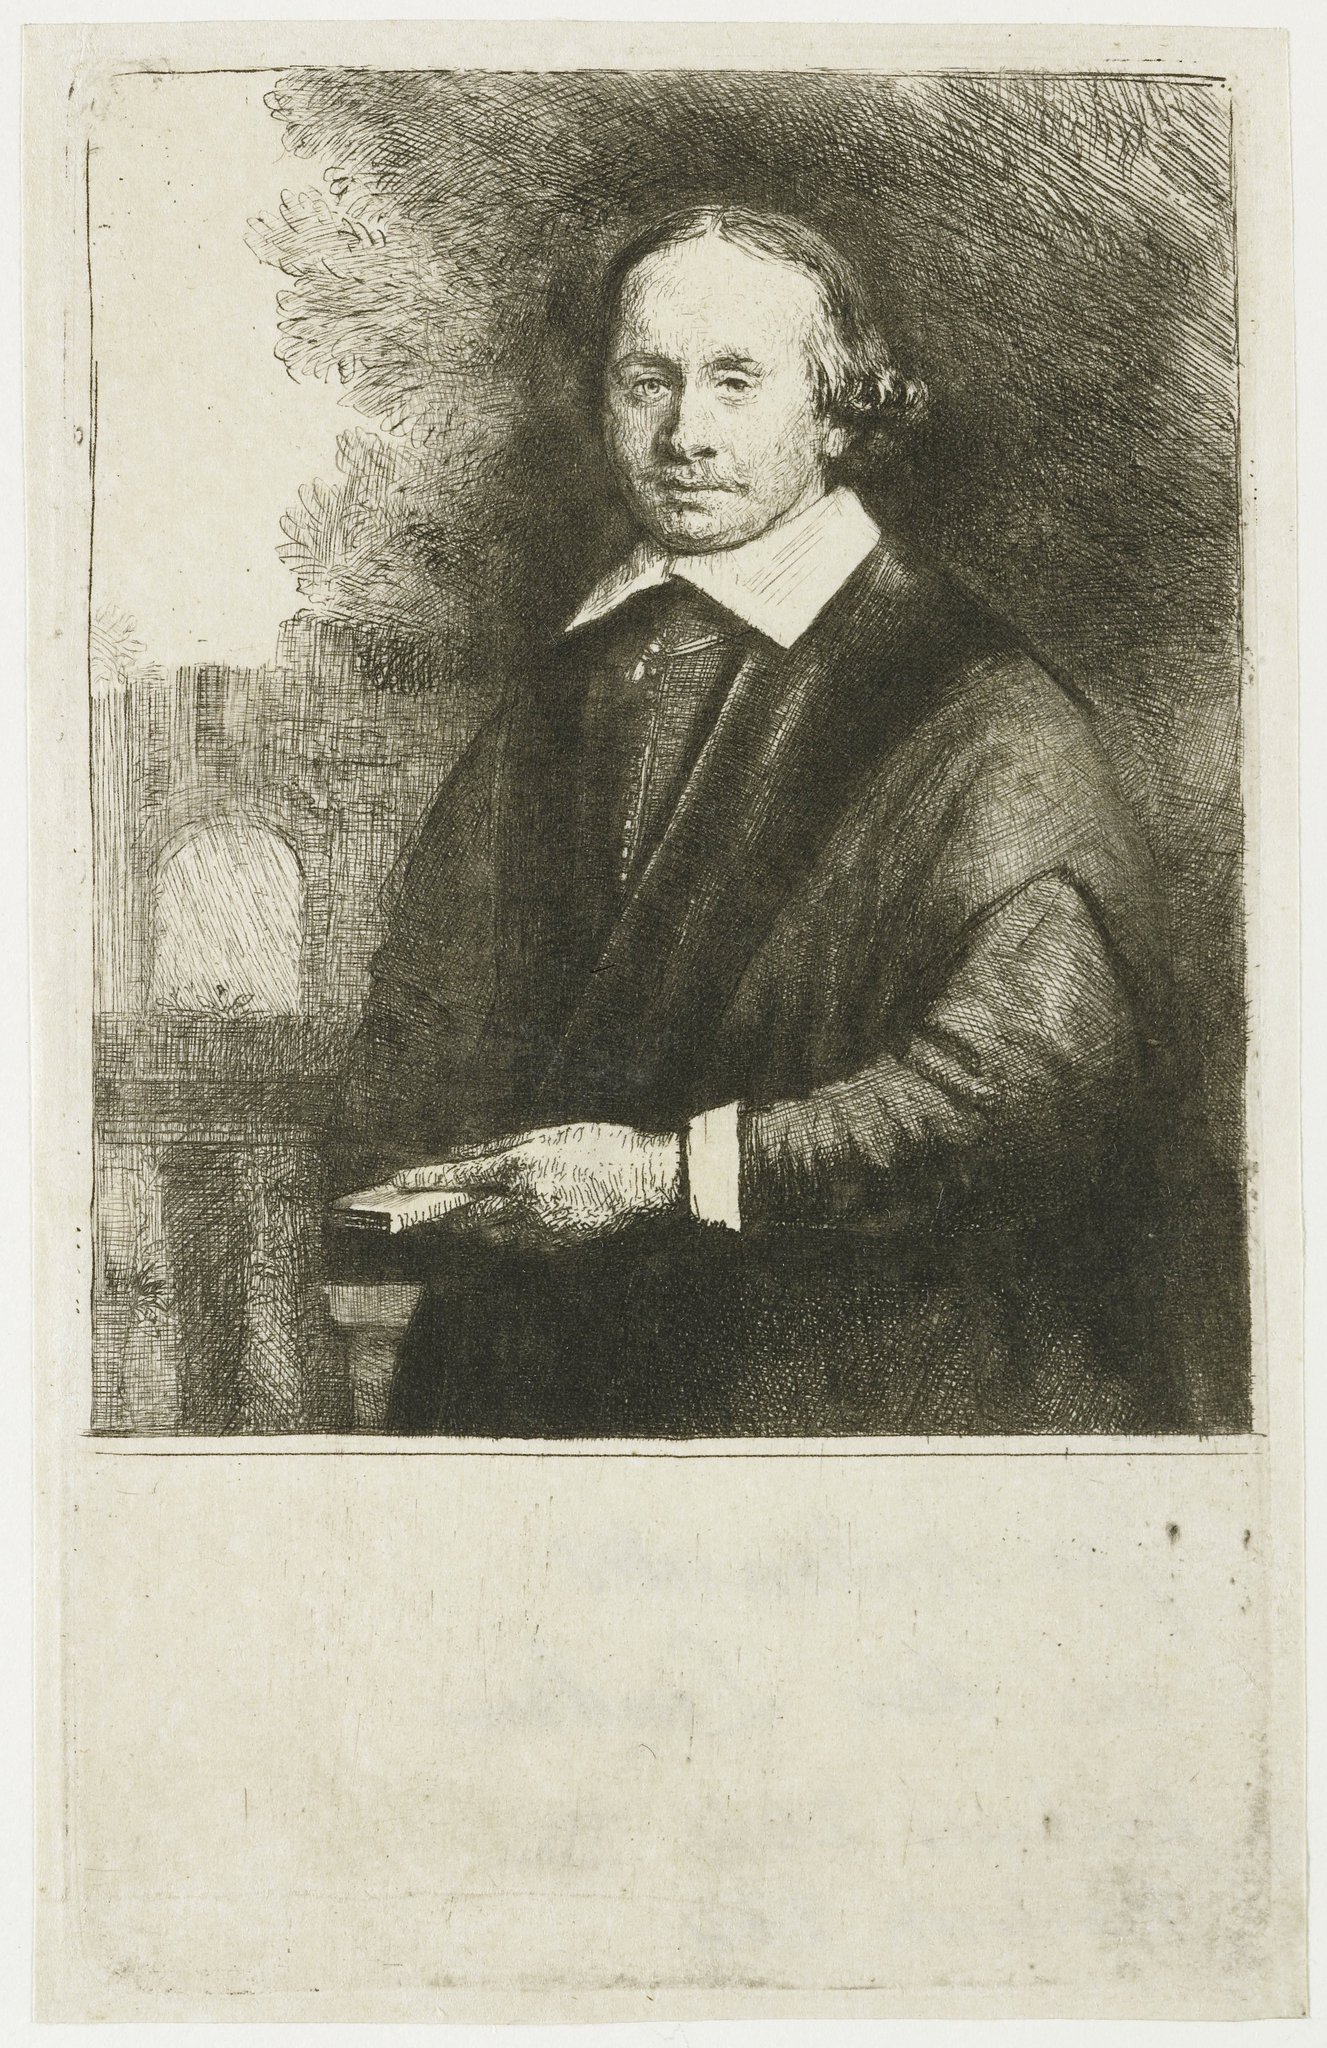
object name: print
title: Jan Antonides van der Linden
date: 1665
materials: paper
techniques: drypoint, etching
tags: enkhuizen, leiden, jan antonides van der linden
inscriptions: collector's mark: Lugt 964, collector's mark: Lugt 2228 a